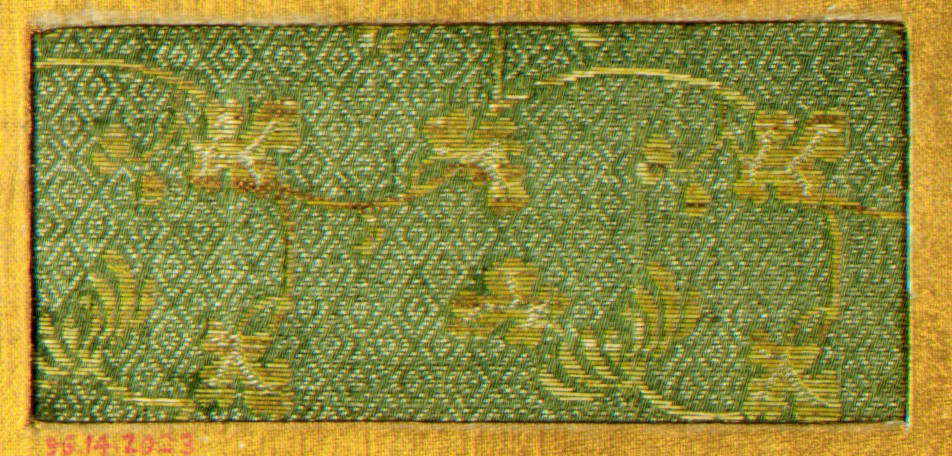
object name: piece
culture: japanese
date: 1701-1900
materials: silk